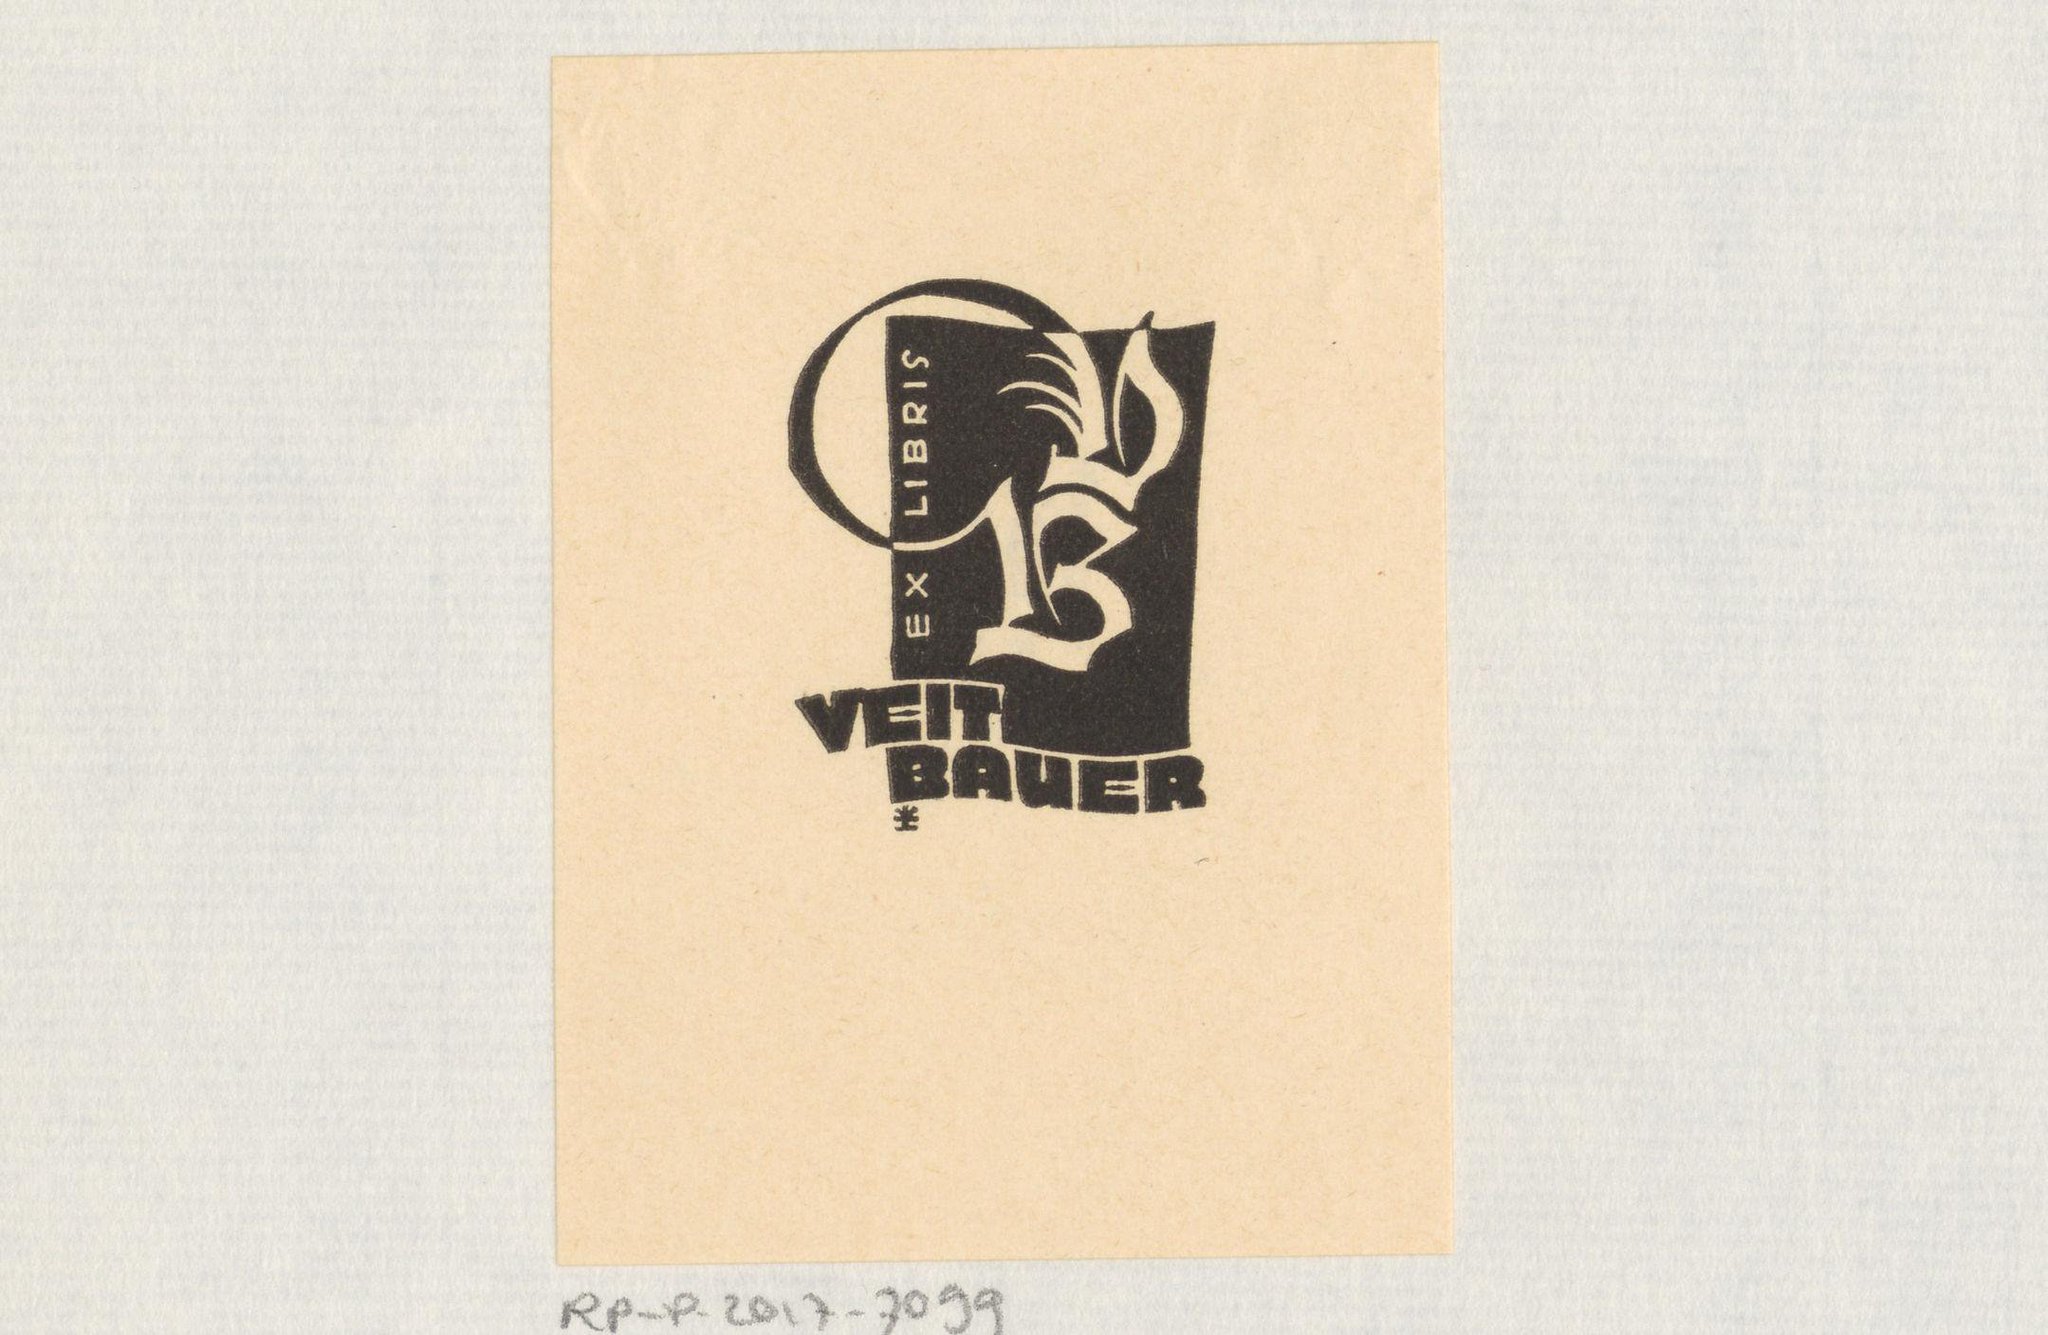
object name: bookplate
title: Ex libris van Veit Bauer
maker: karl haselböck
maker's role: print maker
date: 1935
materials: paper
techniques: engraving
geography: austria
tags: veit bauer